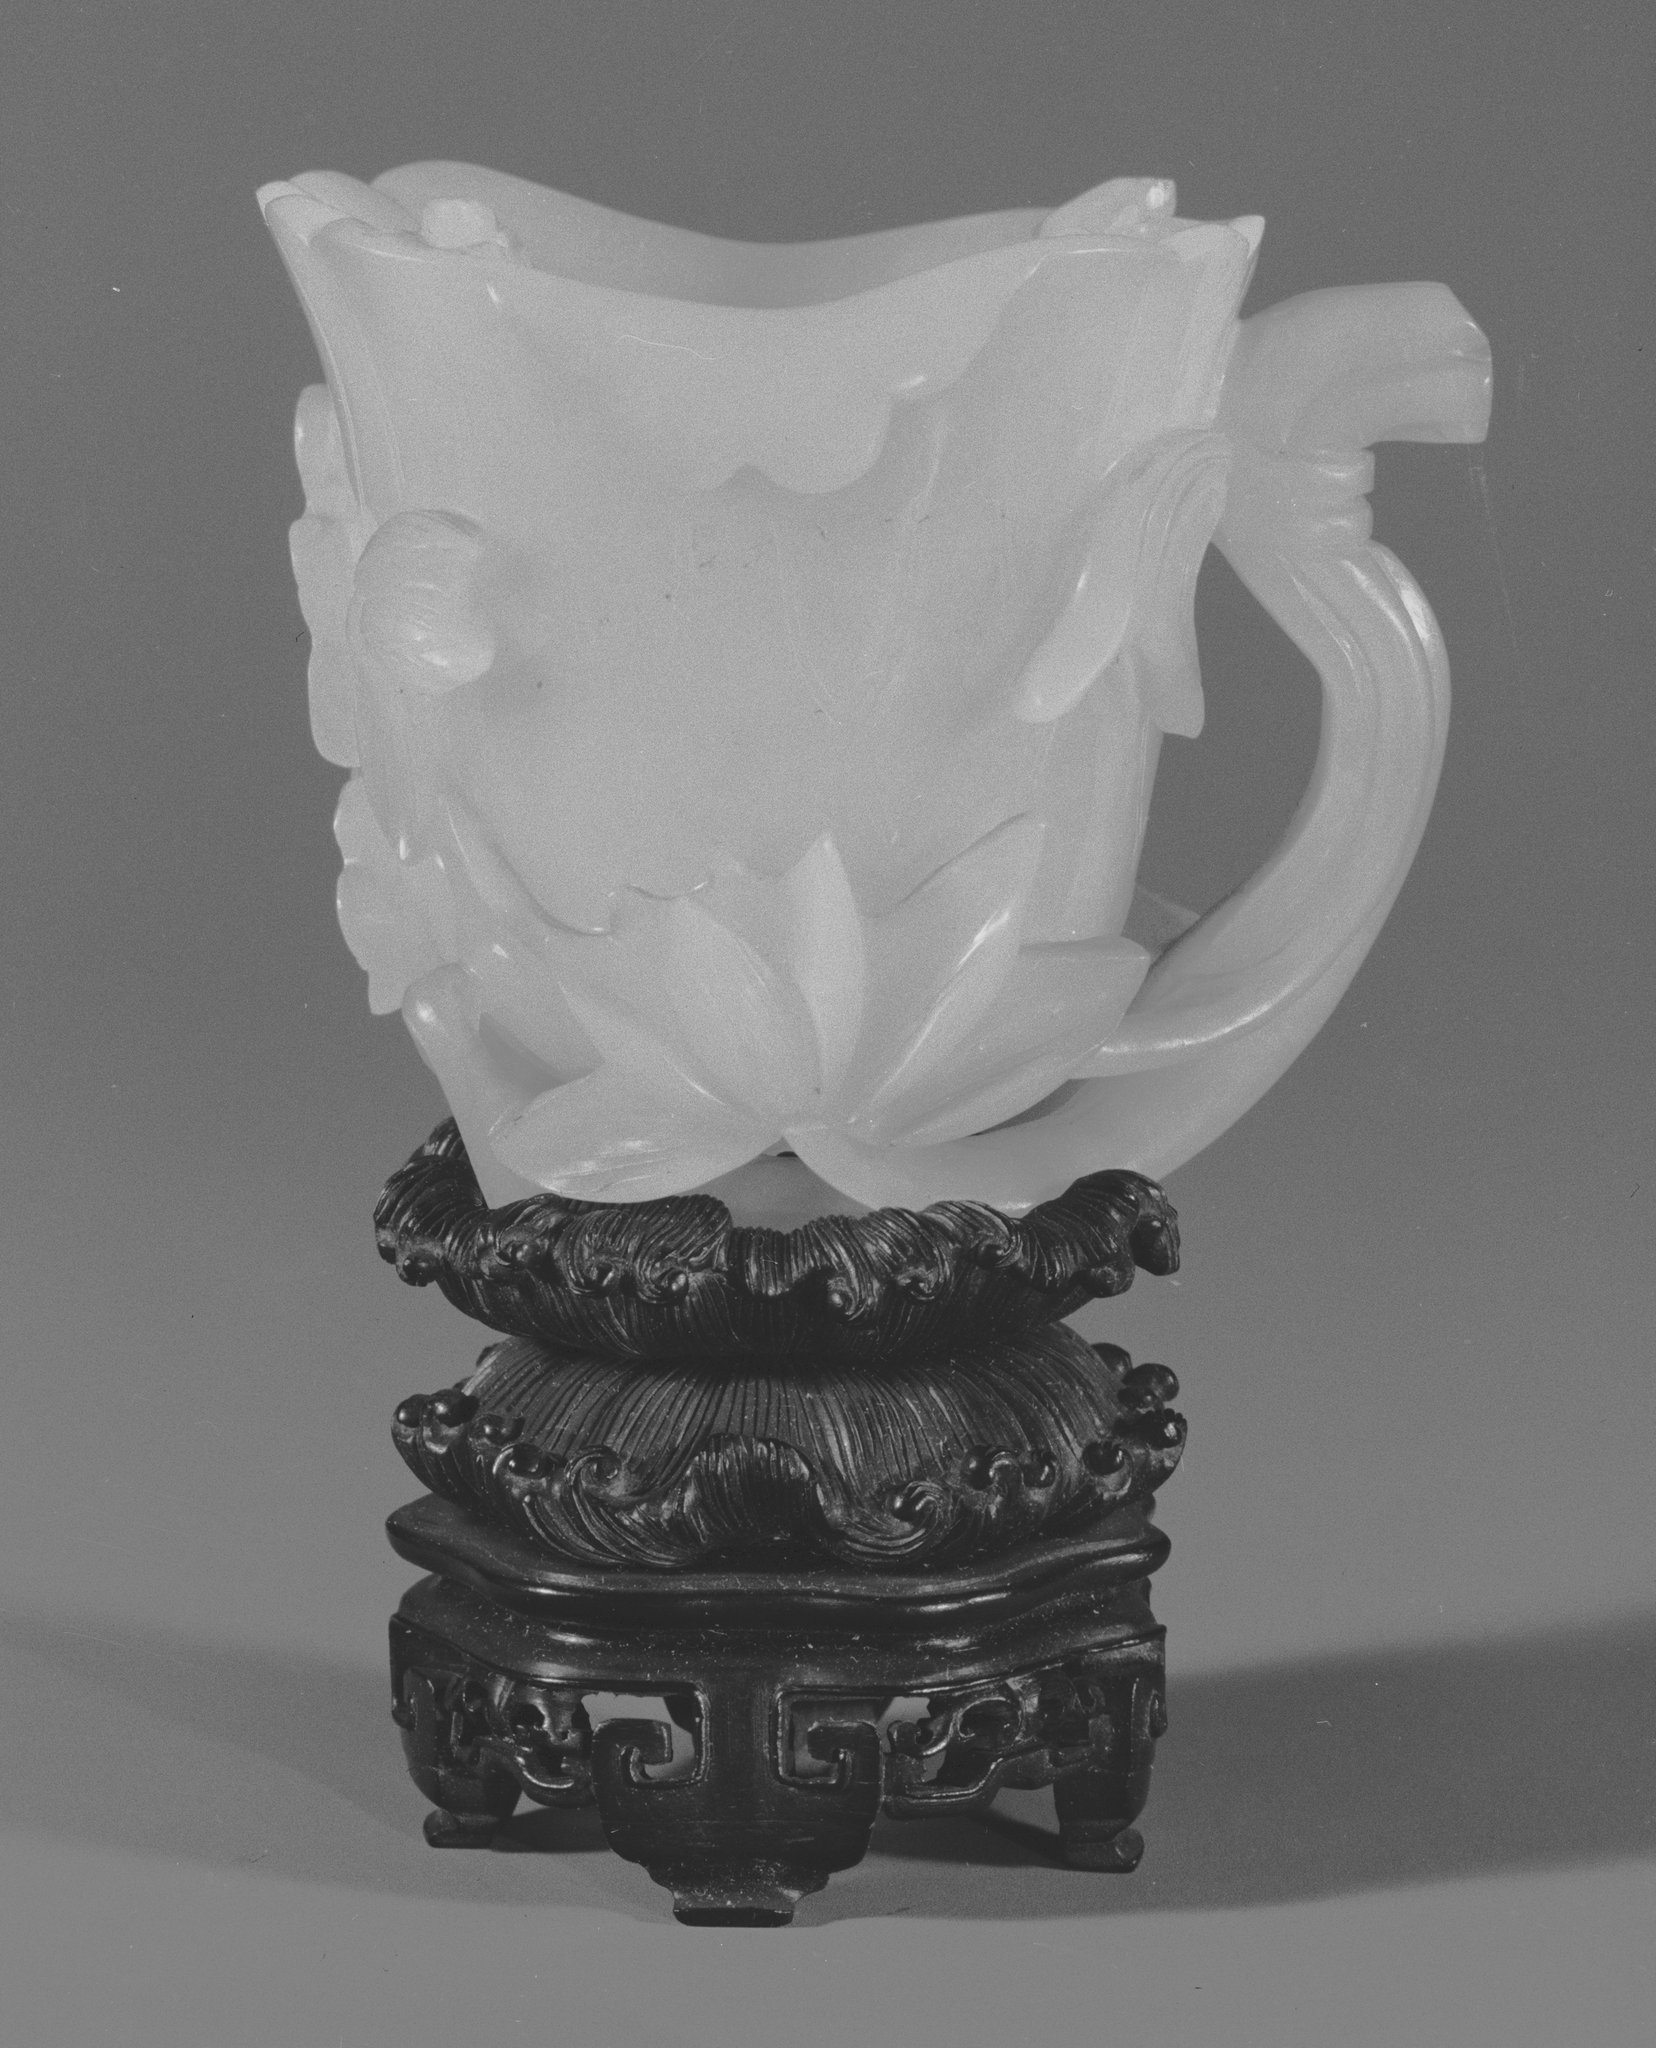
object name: cup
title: Lotus-Shaped Cup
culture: chinese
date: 1701-1800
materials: jade